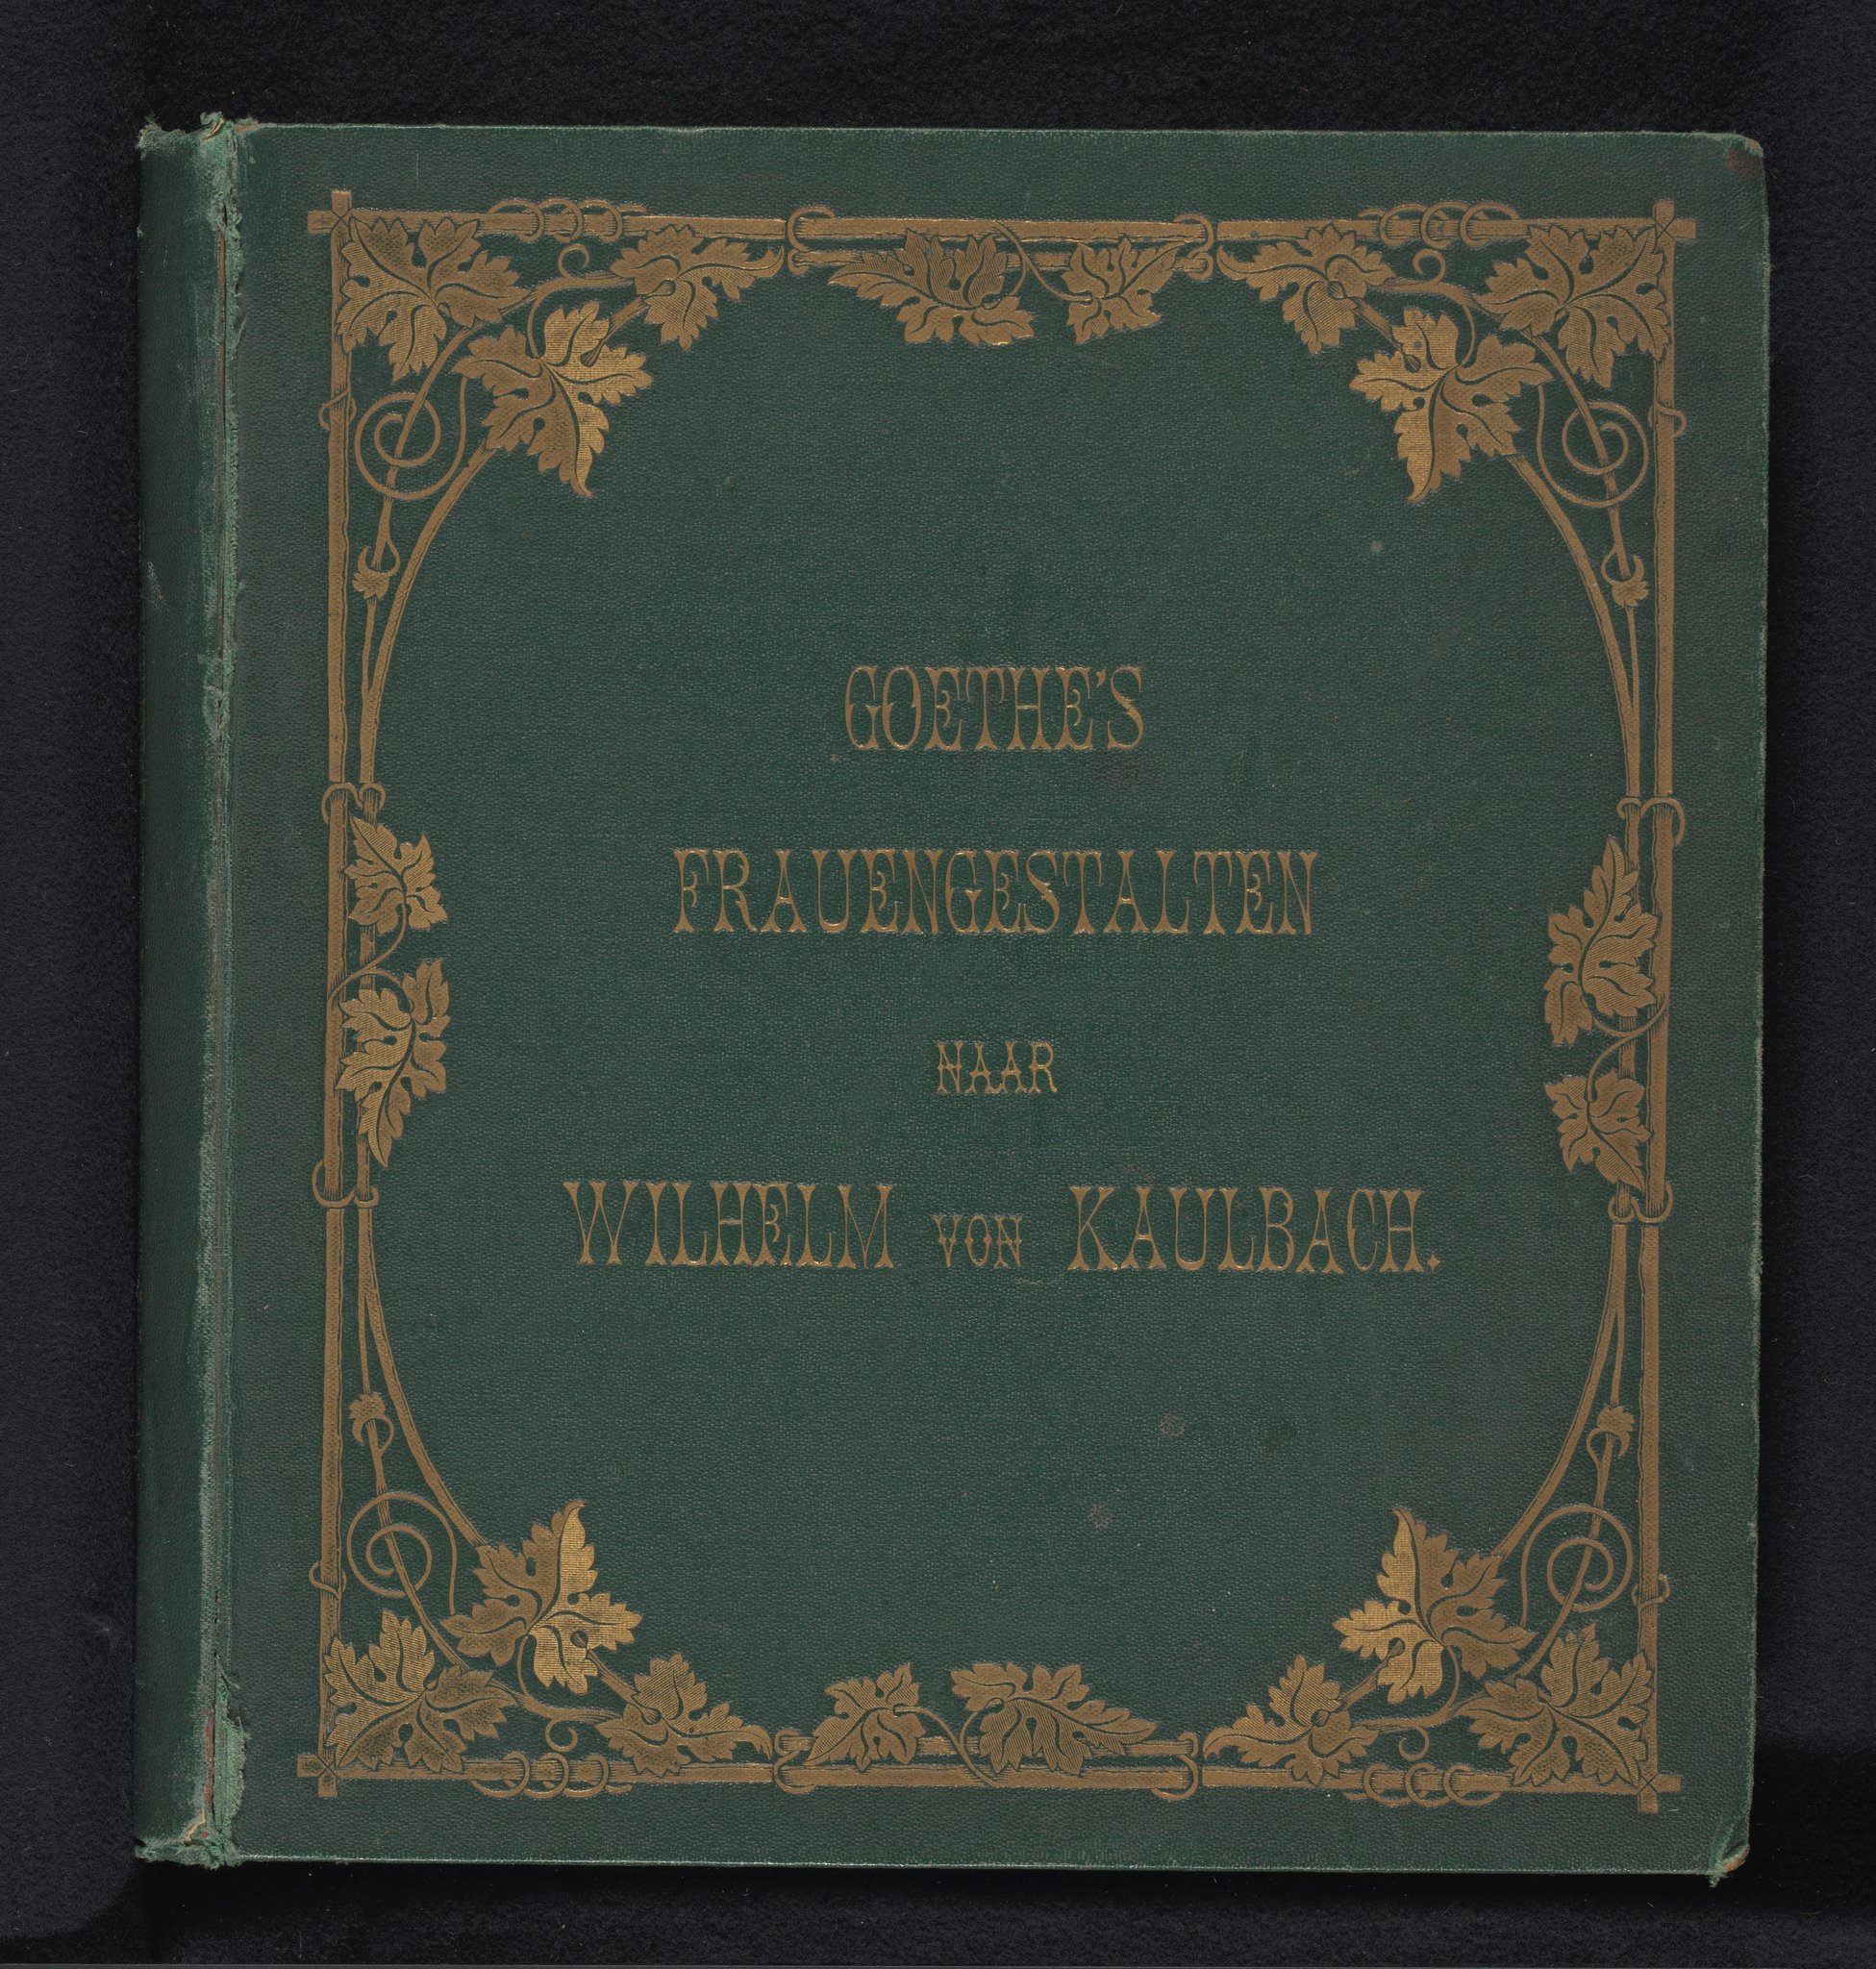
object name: box album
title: Goethe's Frauengestalten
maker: Anonymous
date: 1860-1900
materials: cardboard, linen, paper, photographic support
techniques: albumen print, printing, marbling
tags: (story of the) muses; 'muse' (ripa), specific works of literature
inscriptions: number: ‘f 25-’, collector's mark: ‘DIENST/ VERSPREIDE/ RIJKSKOLLEKTIES/ (...) A851’